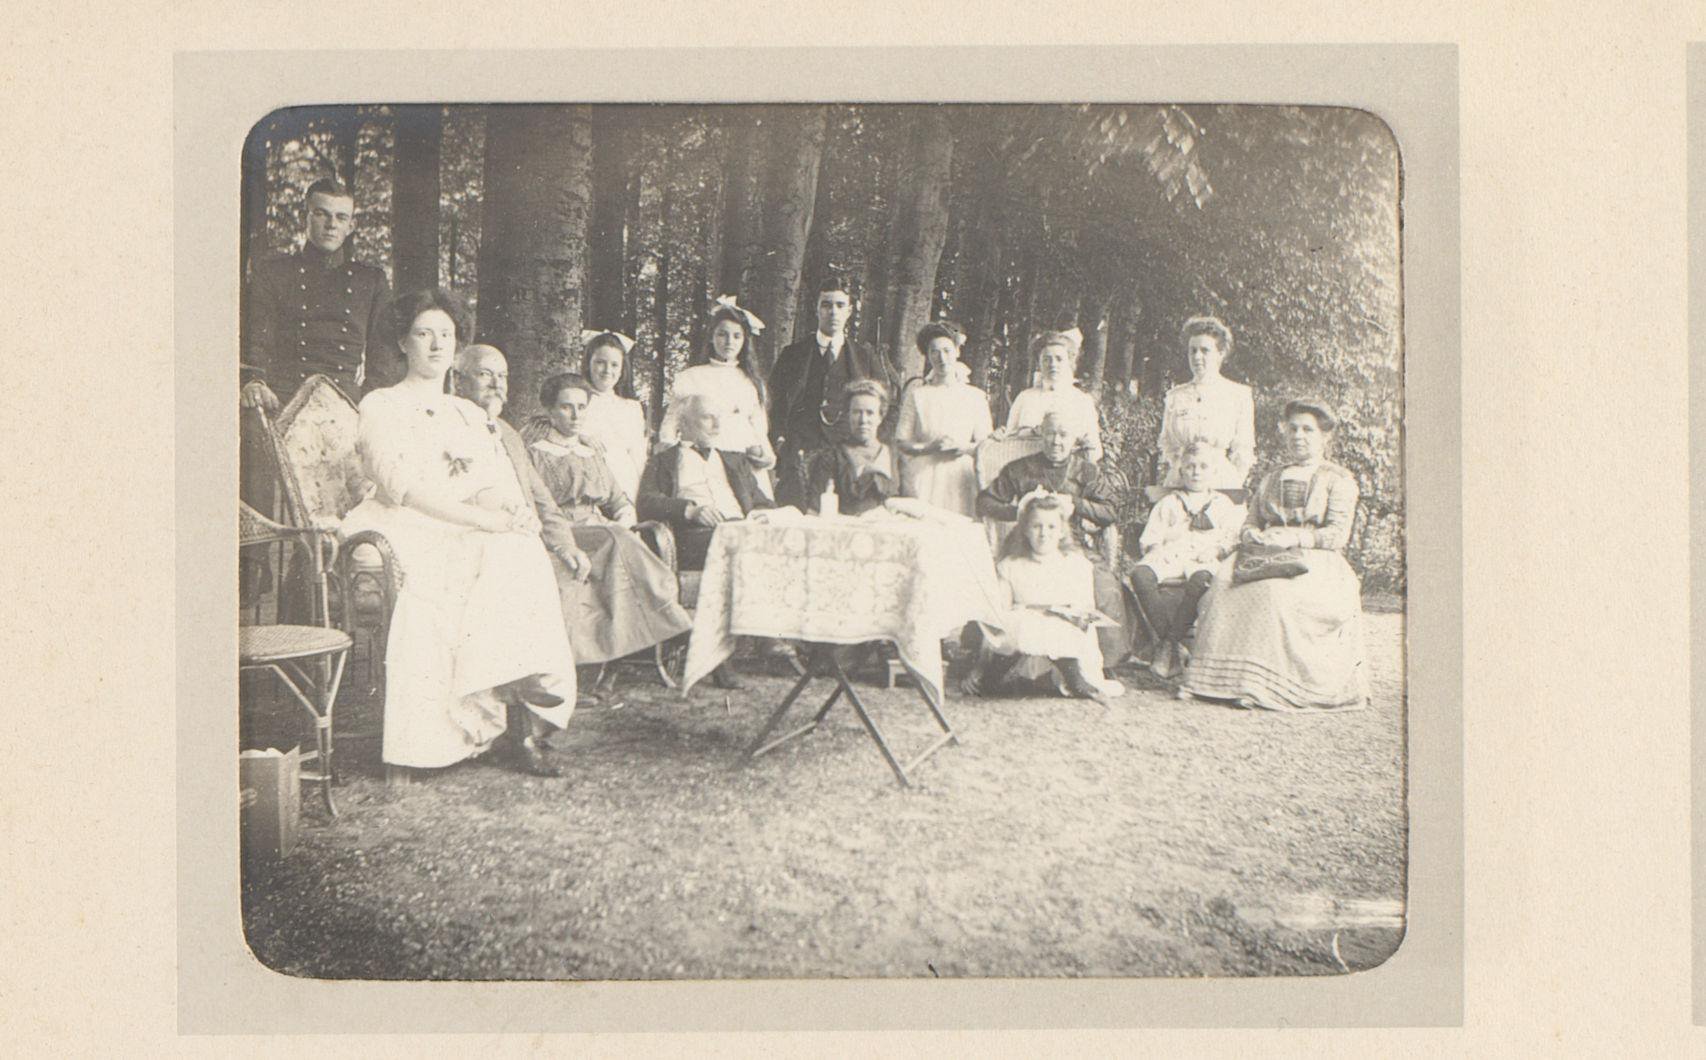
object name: album leaf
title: Groepsportret van een gezelschap rondom een tafel in de bossen bij Ellecom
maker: liesbeth overhoff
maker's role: fotograaf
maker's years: 1895-1969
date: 1911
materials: paper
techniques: gelatin silver print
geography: ellecom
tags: midday meal, lunch - cc - out of doors, forest, wood, anonymous historical persons portrayed in a group, in a group-portrait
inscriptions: inscription: ‘Ellekom’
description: De foto is vanuit iets andere hoek genomen dan RP-F-F01201-16-2.